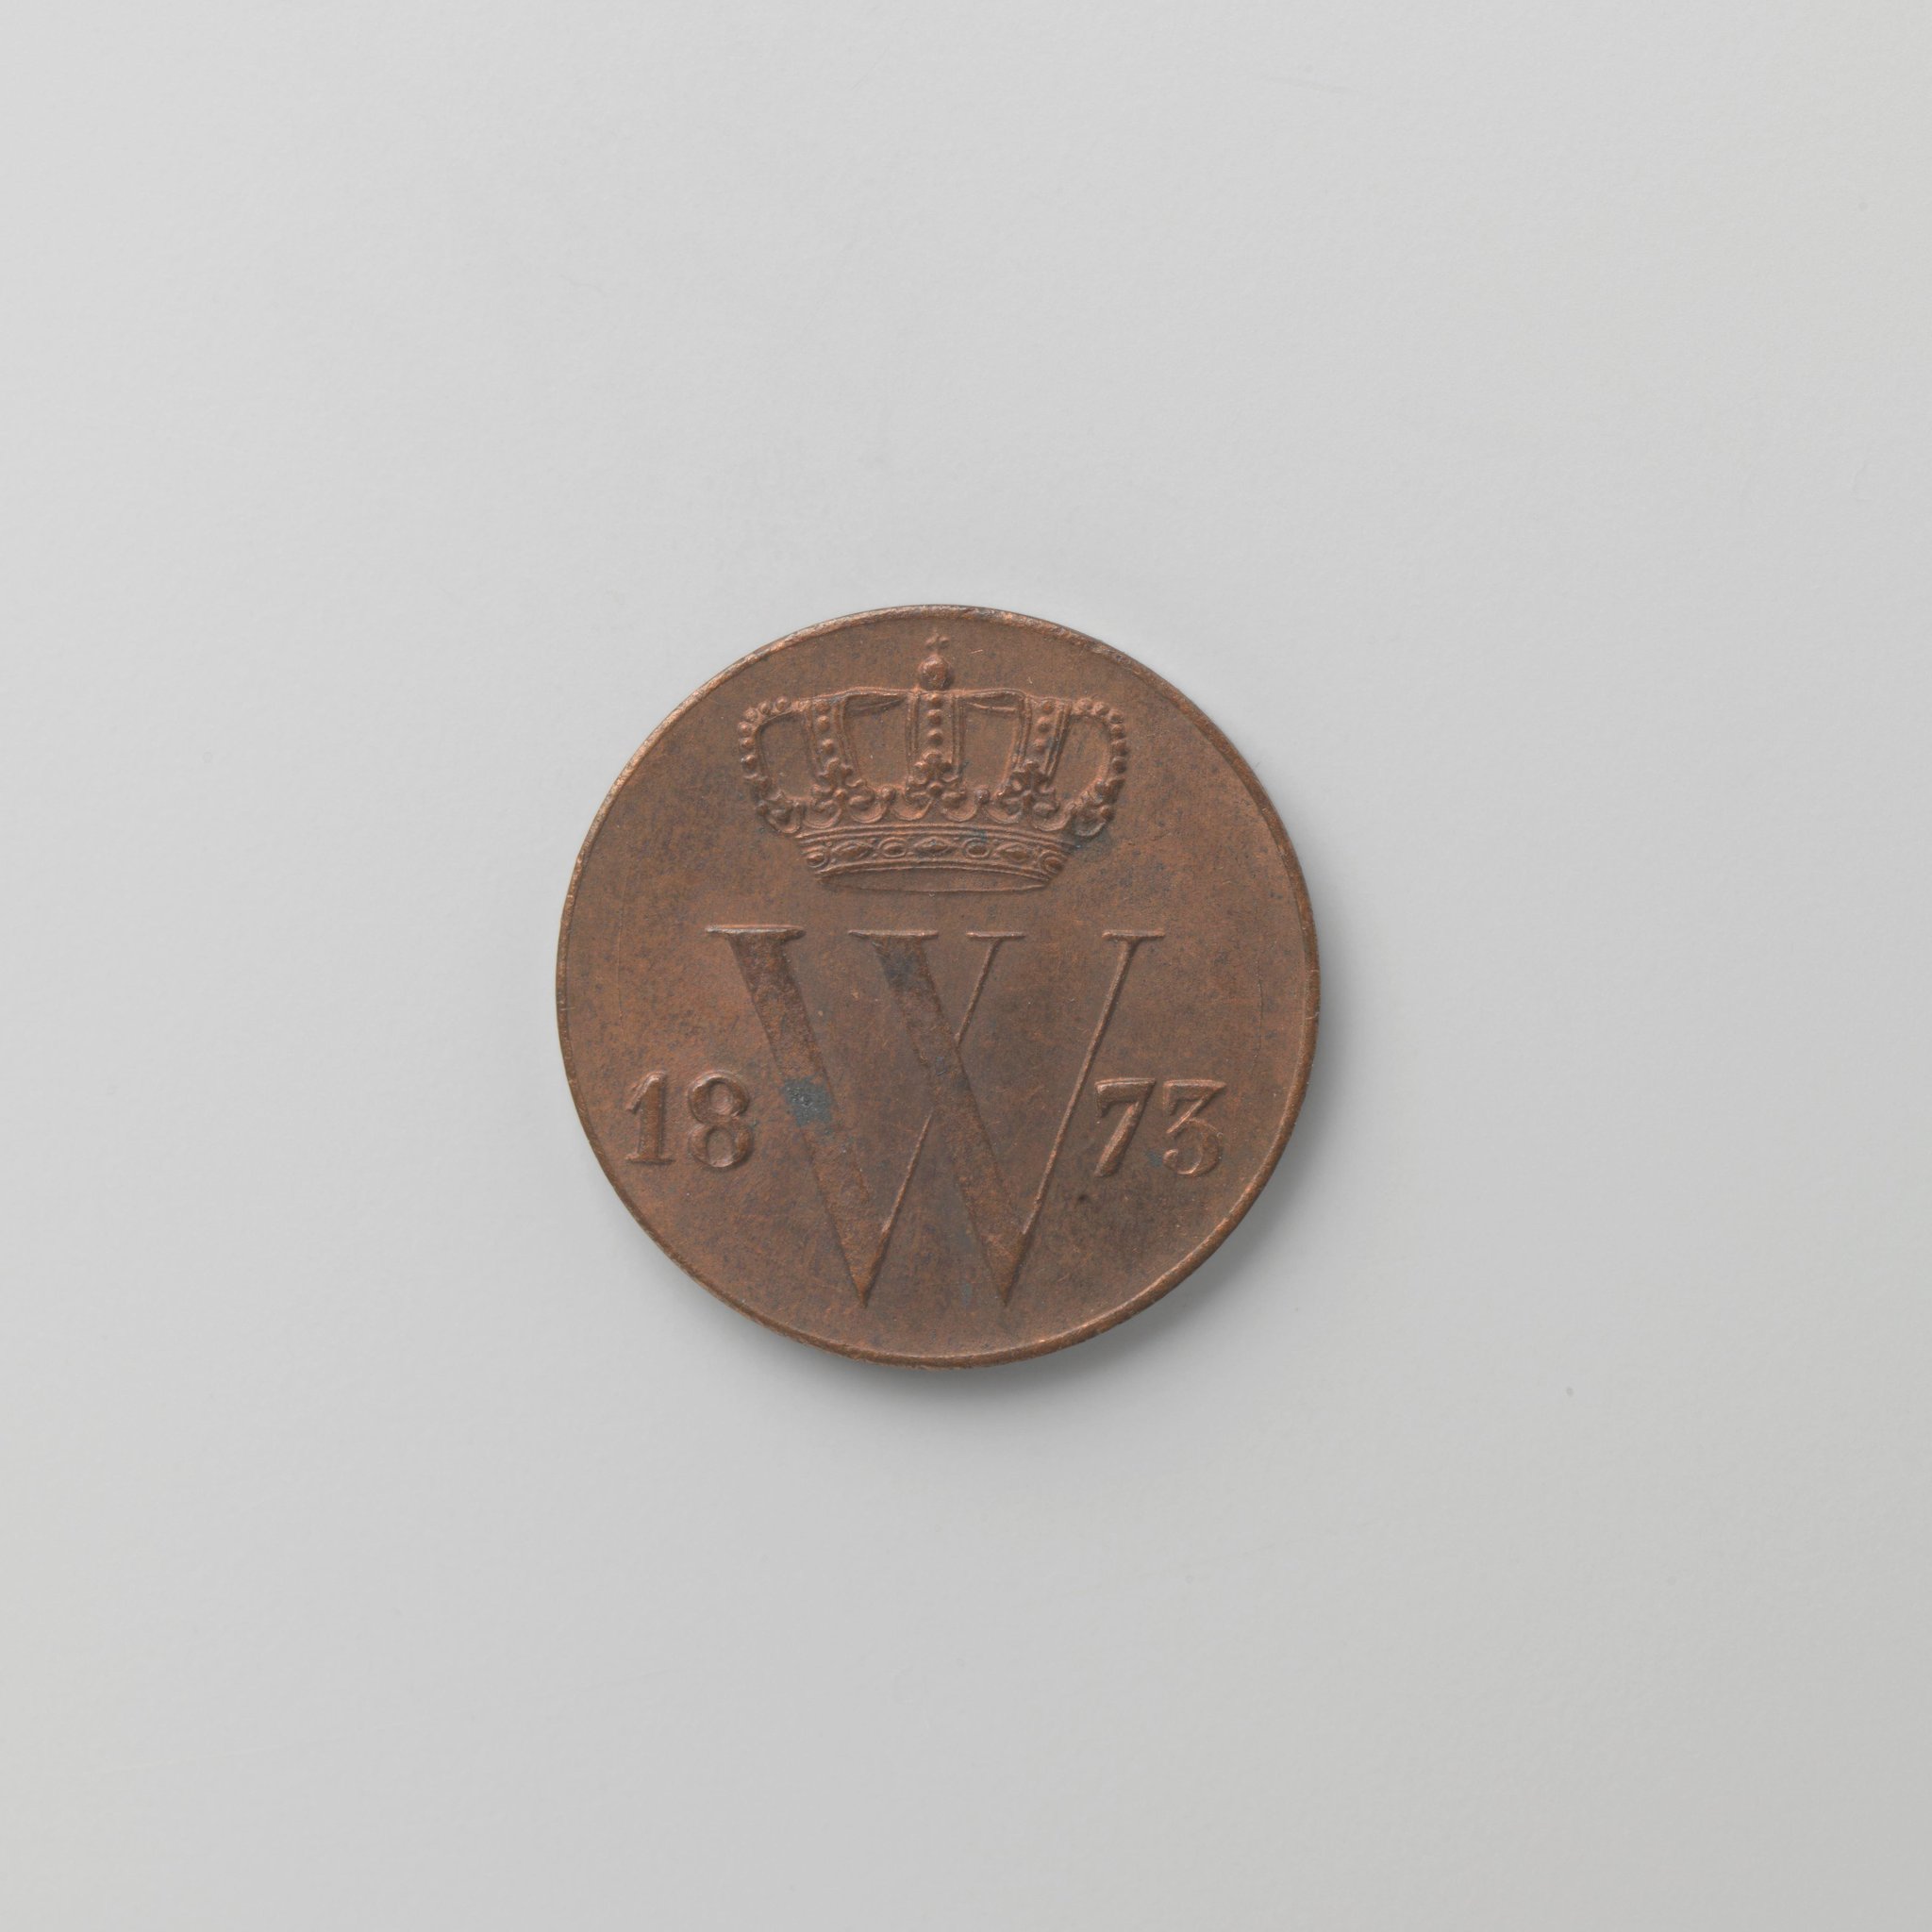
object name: coin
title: Nederlandse ½ cent, 1873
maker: willem iii (koning der nederlanden)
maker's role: koning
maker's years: 1817-1890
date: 1873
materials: copper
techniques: striking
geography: utrecht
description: Koperen munt. Voorzijde: tussen jaartal gekroonde rechte letter W. Keerzijde: tussen waarde-aanduiding ½ C. gekroond rijkswapenschild. Gladde rand.